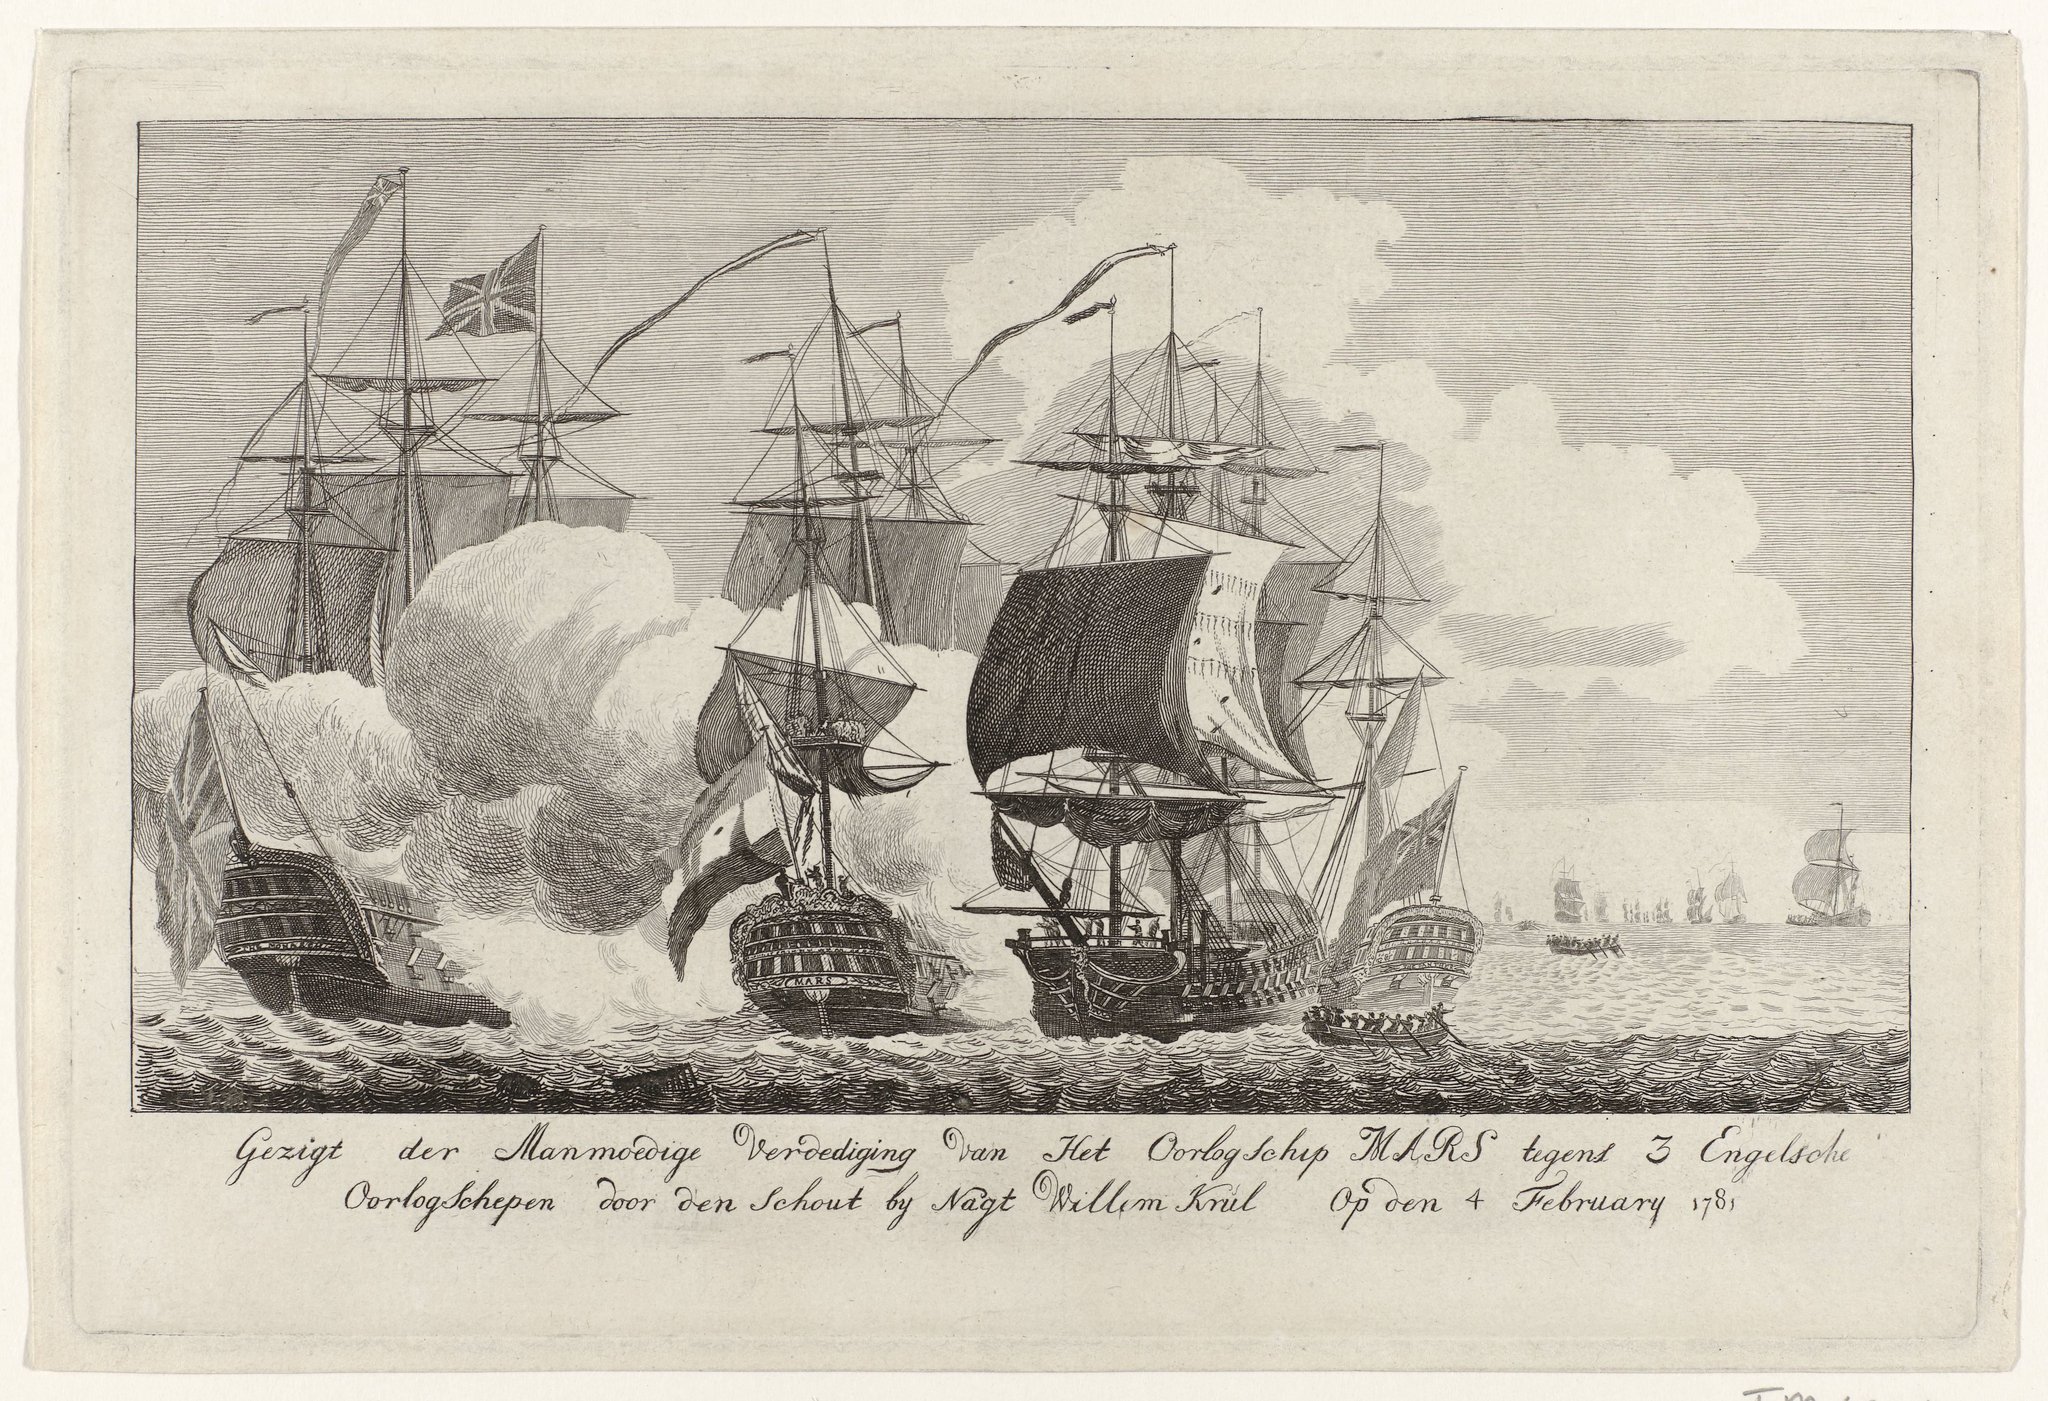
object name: print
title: Gevecht van Willem Crul, 1781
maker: Anonymous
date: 1781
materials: paper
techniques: engraving, etching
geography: northern netherlands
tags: haarlem, battle (+ naval force)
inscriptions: collector's mark: Lugt 2228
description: Het Nederlandse oorlogsschip Mars onder bevel van schout-bij-nacht Willem Crul aangevallen door drie Engelse oorlogsschepen op 4 februari 1781 toen hij met zijn schip een konvooi Nederlandse koopvaarders van Sint-Eustatius begeleidde.